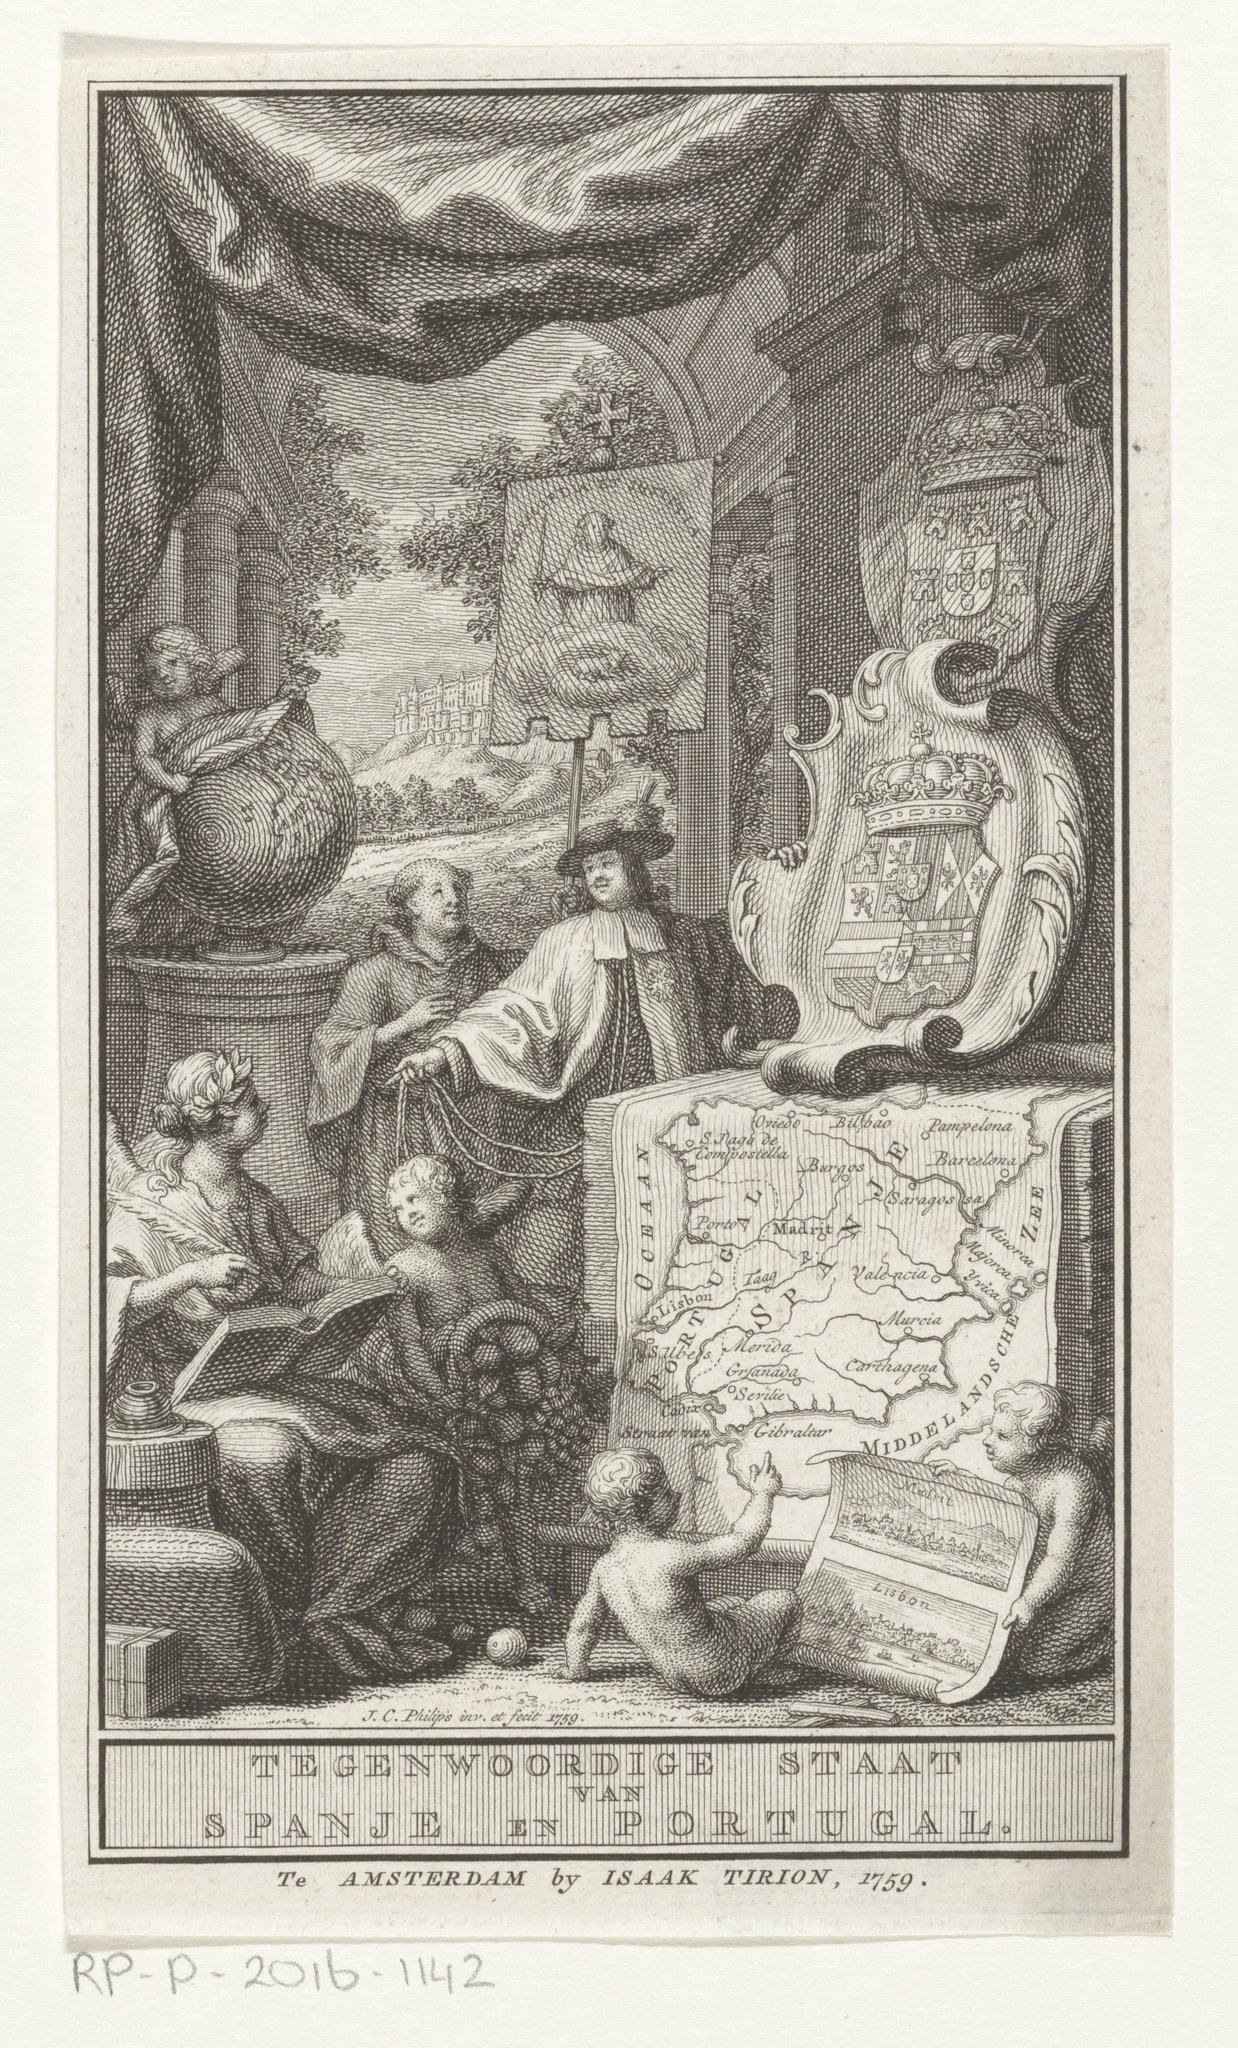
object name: titelblad, titelpagina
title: Tegenwoordige staat van Spanje en Portugal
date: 1759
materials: paper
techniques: engraving, etching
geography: amsterdam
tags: coat of arms (as symbol of the state, etc.), maps, atlases, 'historia'; 'historia' (ripa), cupids: 'amores', 'amoretti', 'putti', spain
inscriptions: collector's mark: Lugt 2228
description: Geschiedenis zit schrijvend naast een kaart van Spanje en Portugal op een voetstuk. Bij haar staan en zitten putti met een hoorn des overvloeds en stadsgezichten van Madrid en Lissabon. Boven het voetstuk de wapenschilden van de twee landen. Daarnaast staan een man met hoed en een dominicaan met banier met Dominicus met zwaard, olijftak en lam. Links onthult een putto de kaart van Amerika op een globe.